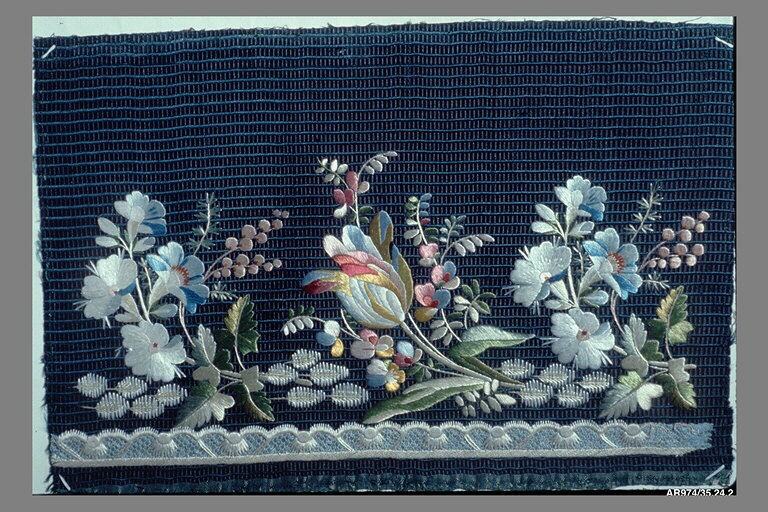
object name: sample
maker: jean françois bony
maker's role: designer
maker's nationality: french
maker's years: 1760-1825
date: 1767-1833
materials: silk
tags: flowers